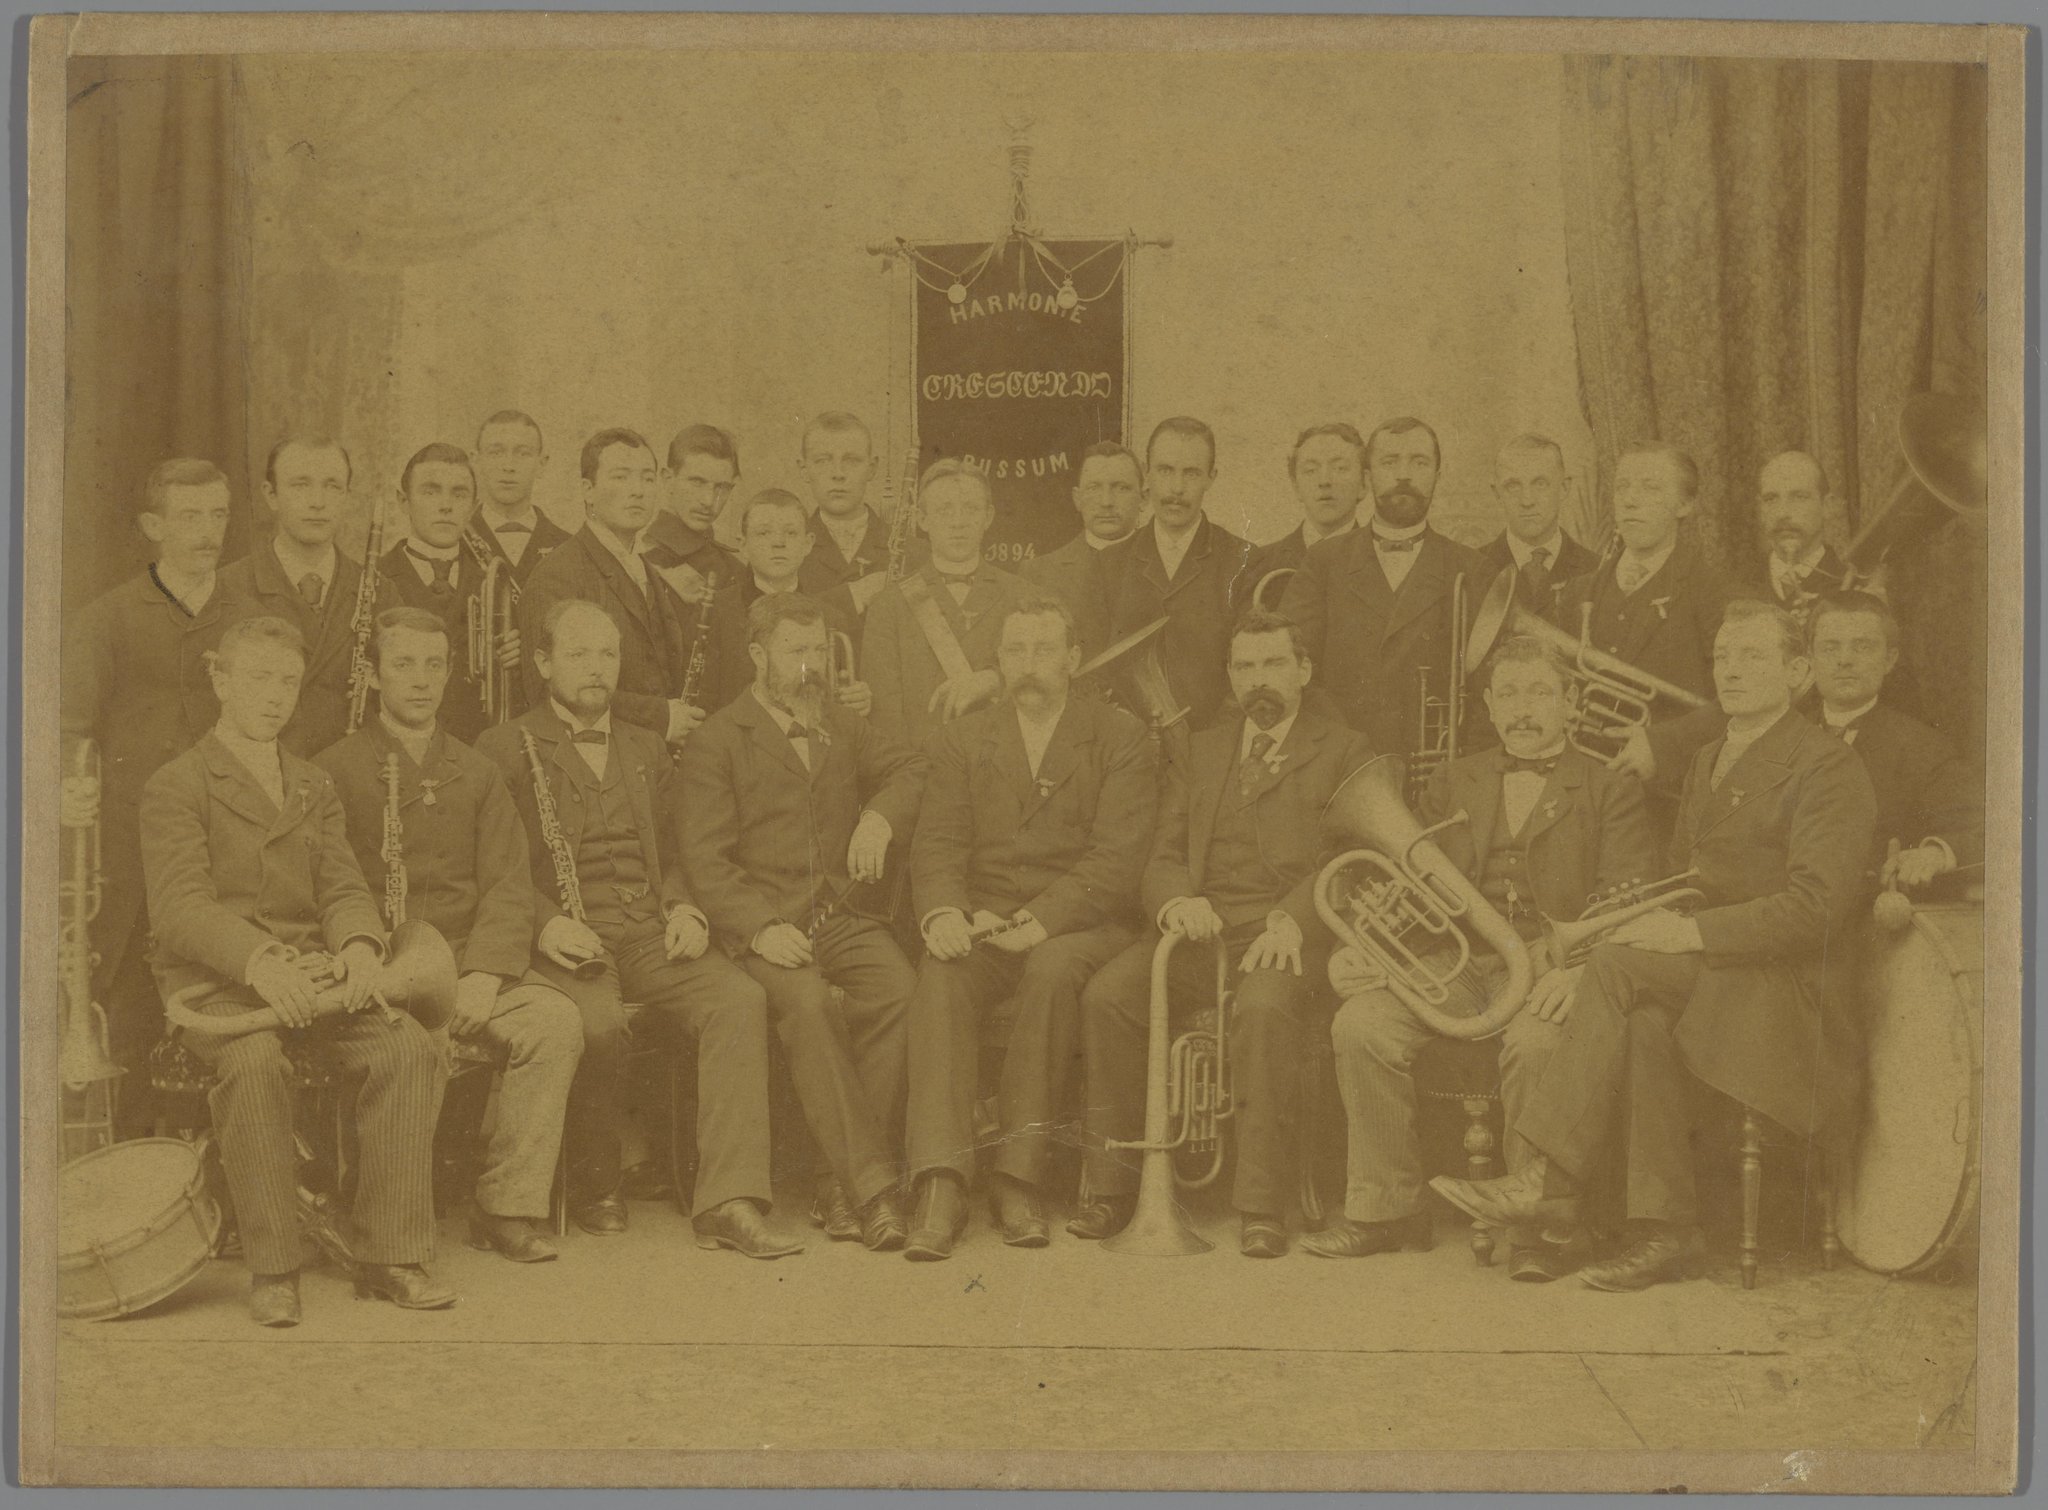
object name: photograph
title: Groepsportret harmonie 'Crescendo'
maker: Anonymous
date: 1894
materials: cardboard, photographic support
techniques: albumen print